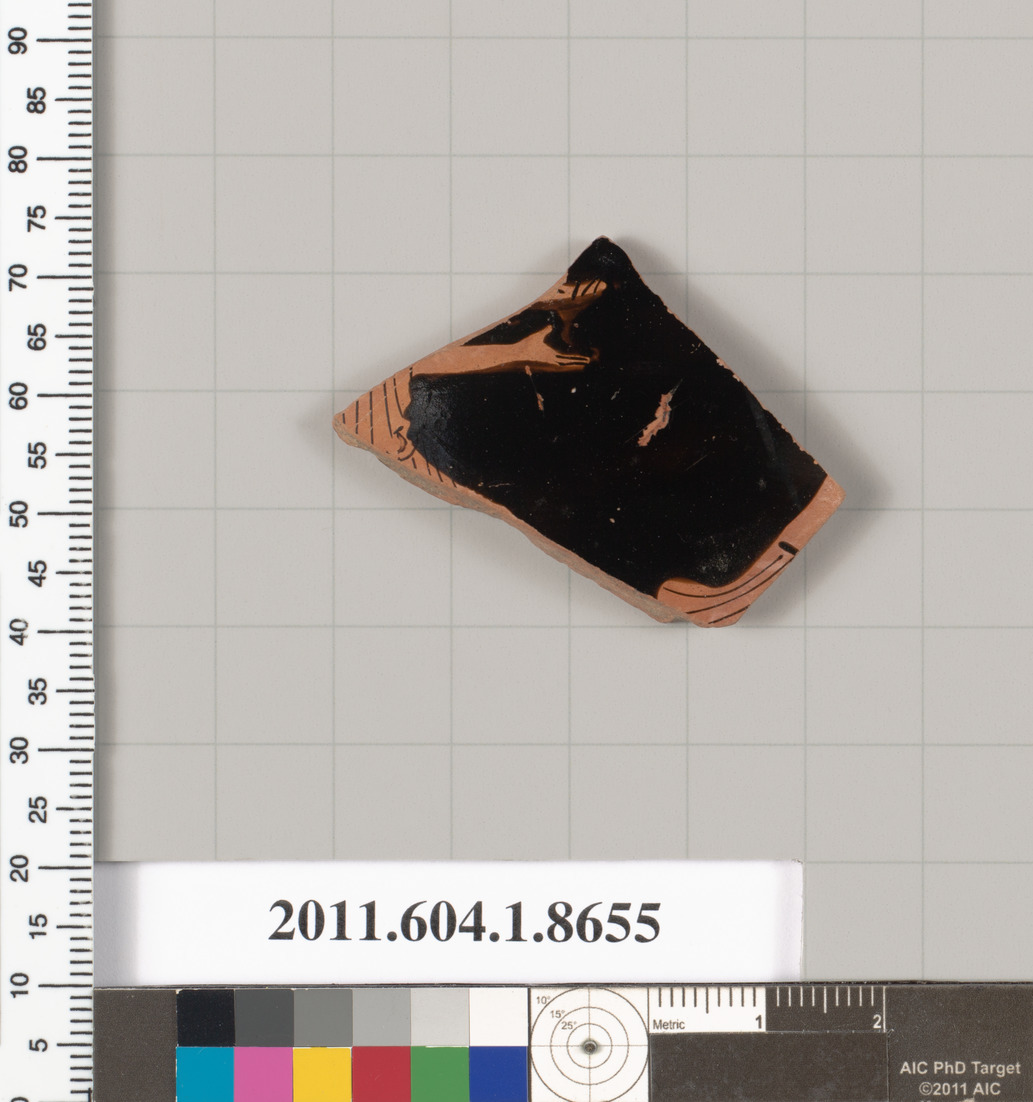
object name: kylix fragment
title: Terracotta rim fragment of a stemless? kylix (drinking cup)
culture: greek, attic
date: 467-435 BCE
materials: terracotta